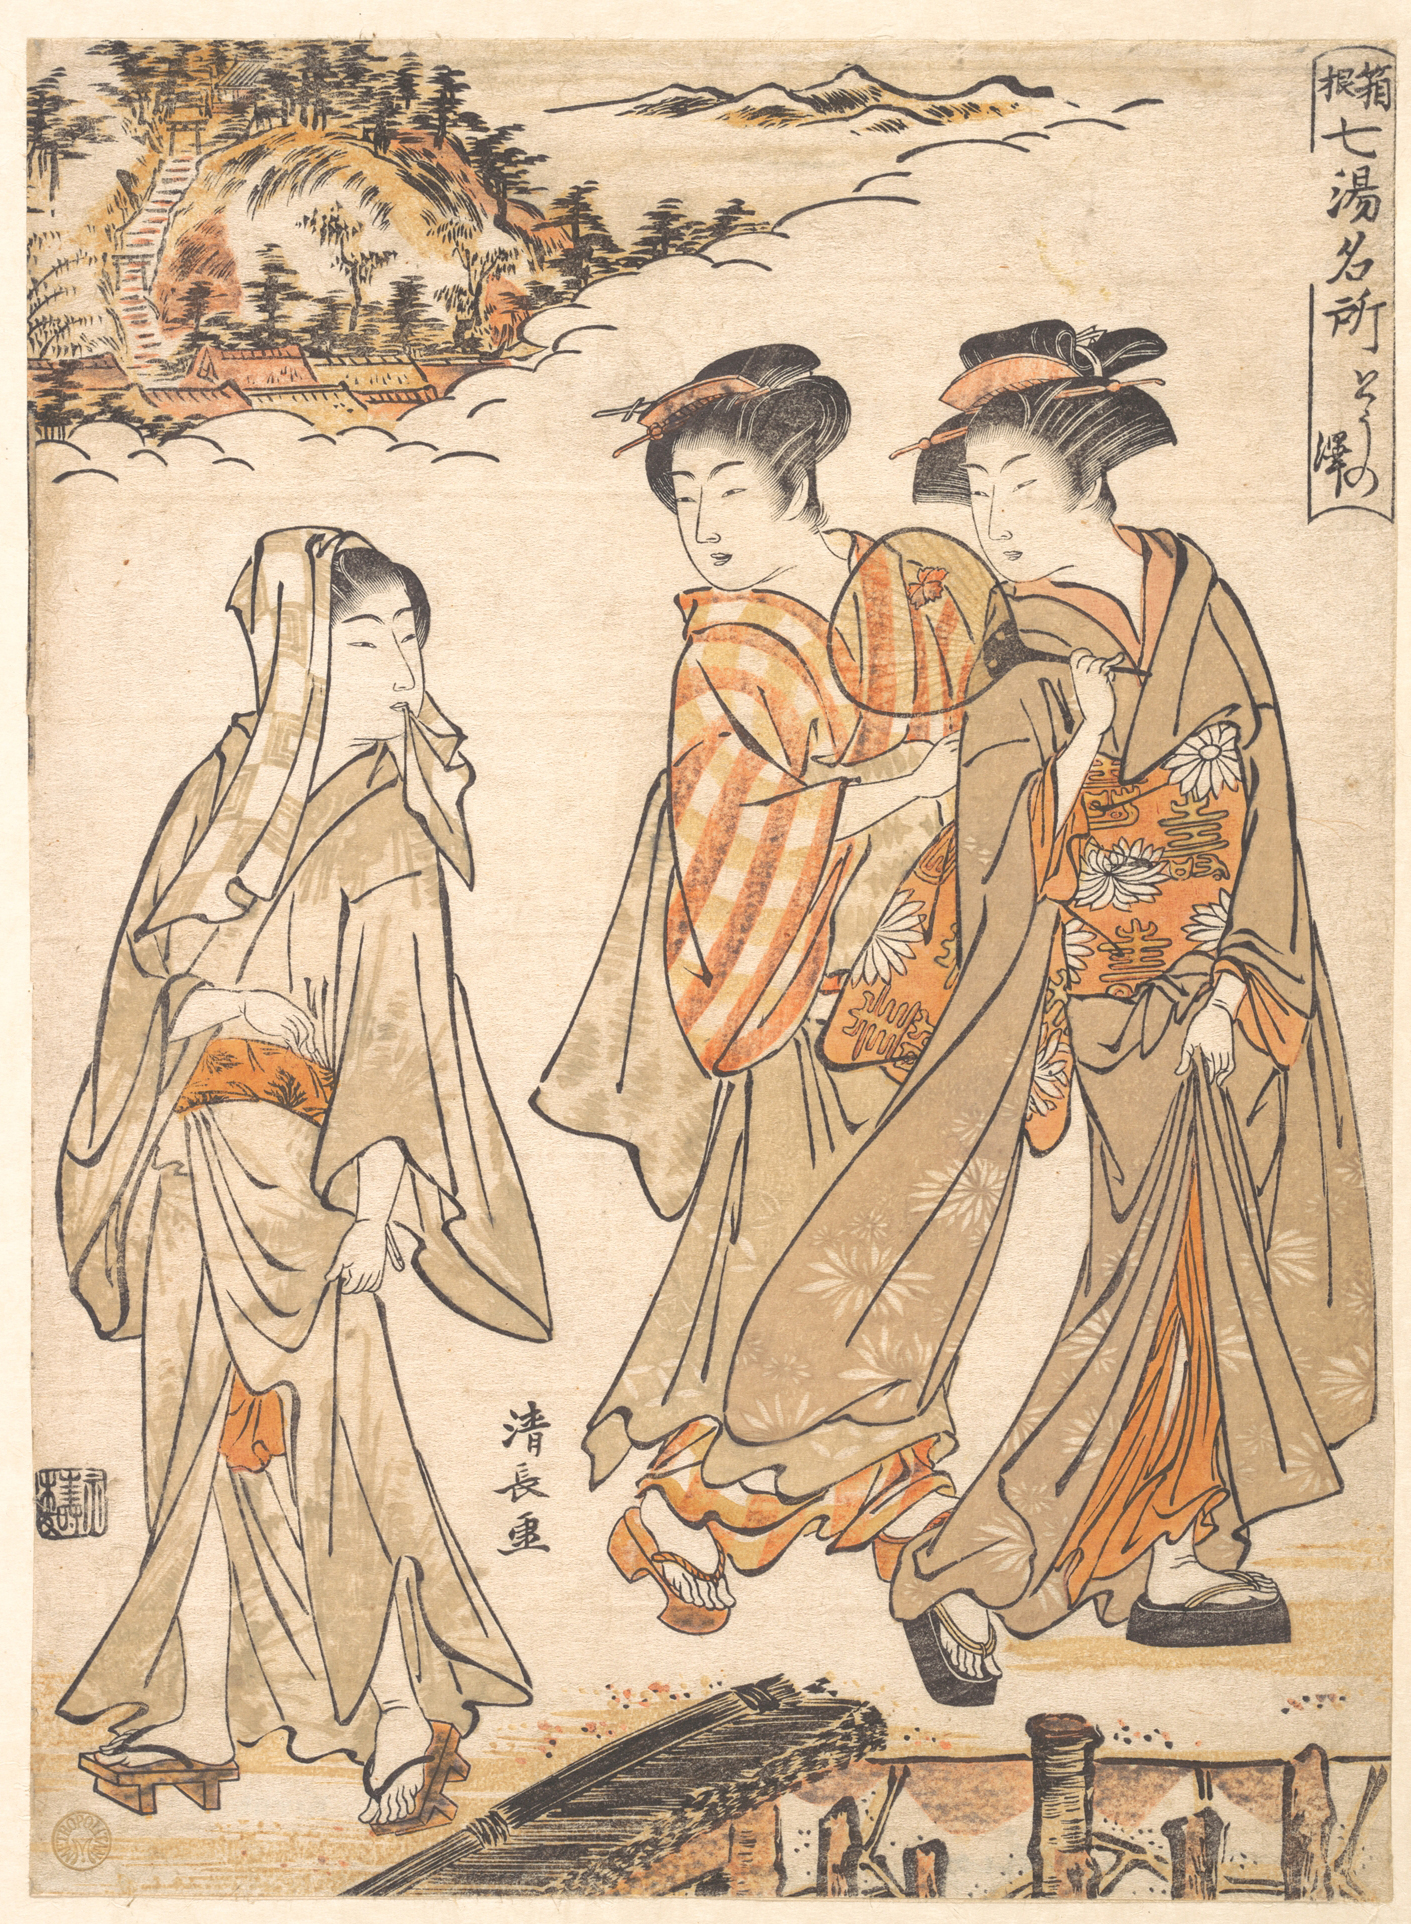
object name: print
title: To-no Sawa (Name of one of the hot springs at Hakone)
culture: japanese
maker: torii kiyonaga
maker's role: artist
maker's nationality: japanese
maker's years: 1752-1815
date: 1779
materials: ink, paper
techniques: woodblock print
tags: women,actors